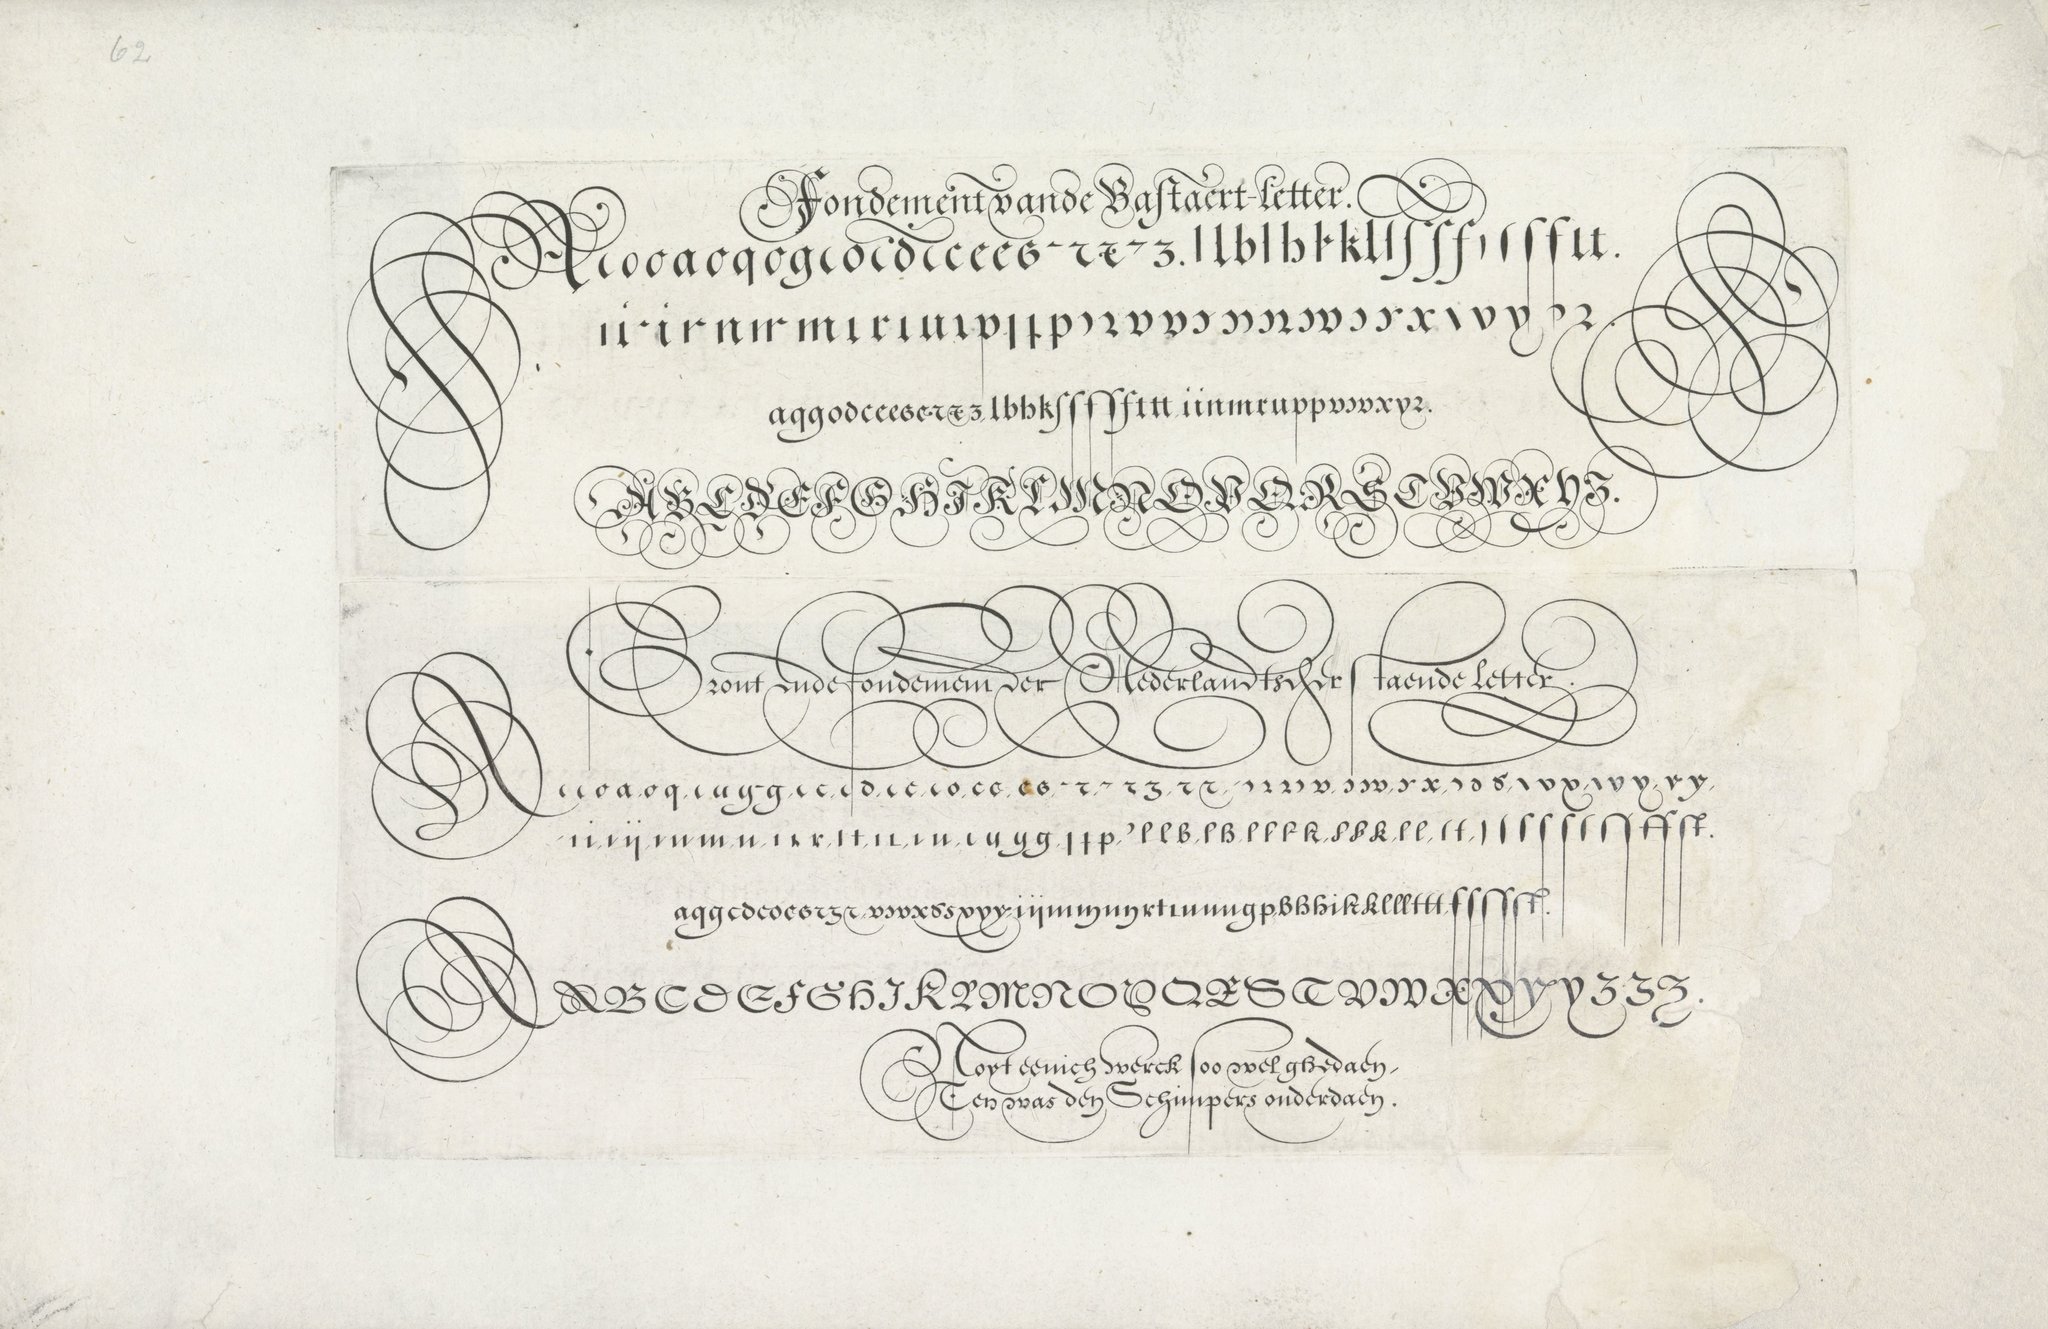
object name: ornament print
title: Fondement vande Bastaert-letter / Gront ende fondement der Nederlandtsche staende letter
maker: simon frisius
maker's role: print maker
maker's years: 1570-1628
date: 1605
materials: paper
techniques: engraving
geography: rotterdam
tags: calligraphy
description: Twee voorstellingen op een albumblad. Het gaat om twee schrijfvoorbeelden. Boven vier regels letters met de titel 'Fondement vande Bastaert-letter'. Daaronder vier regels van letters met de titel 'Gront ende fondement der Nederlandtsche staende letter' en twee versregels: Noyt eenich werck ... Beide schrijfvoorbeelden met krulwerk. De prenten maken deel uit van een album.